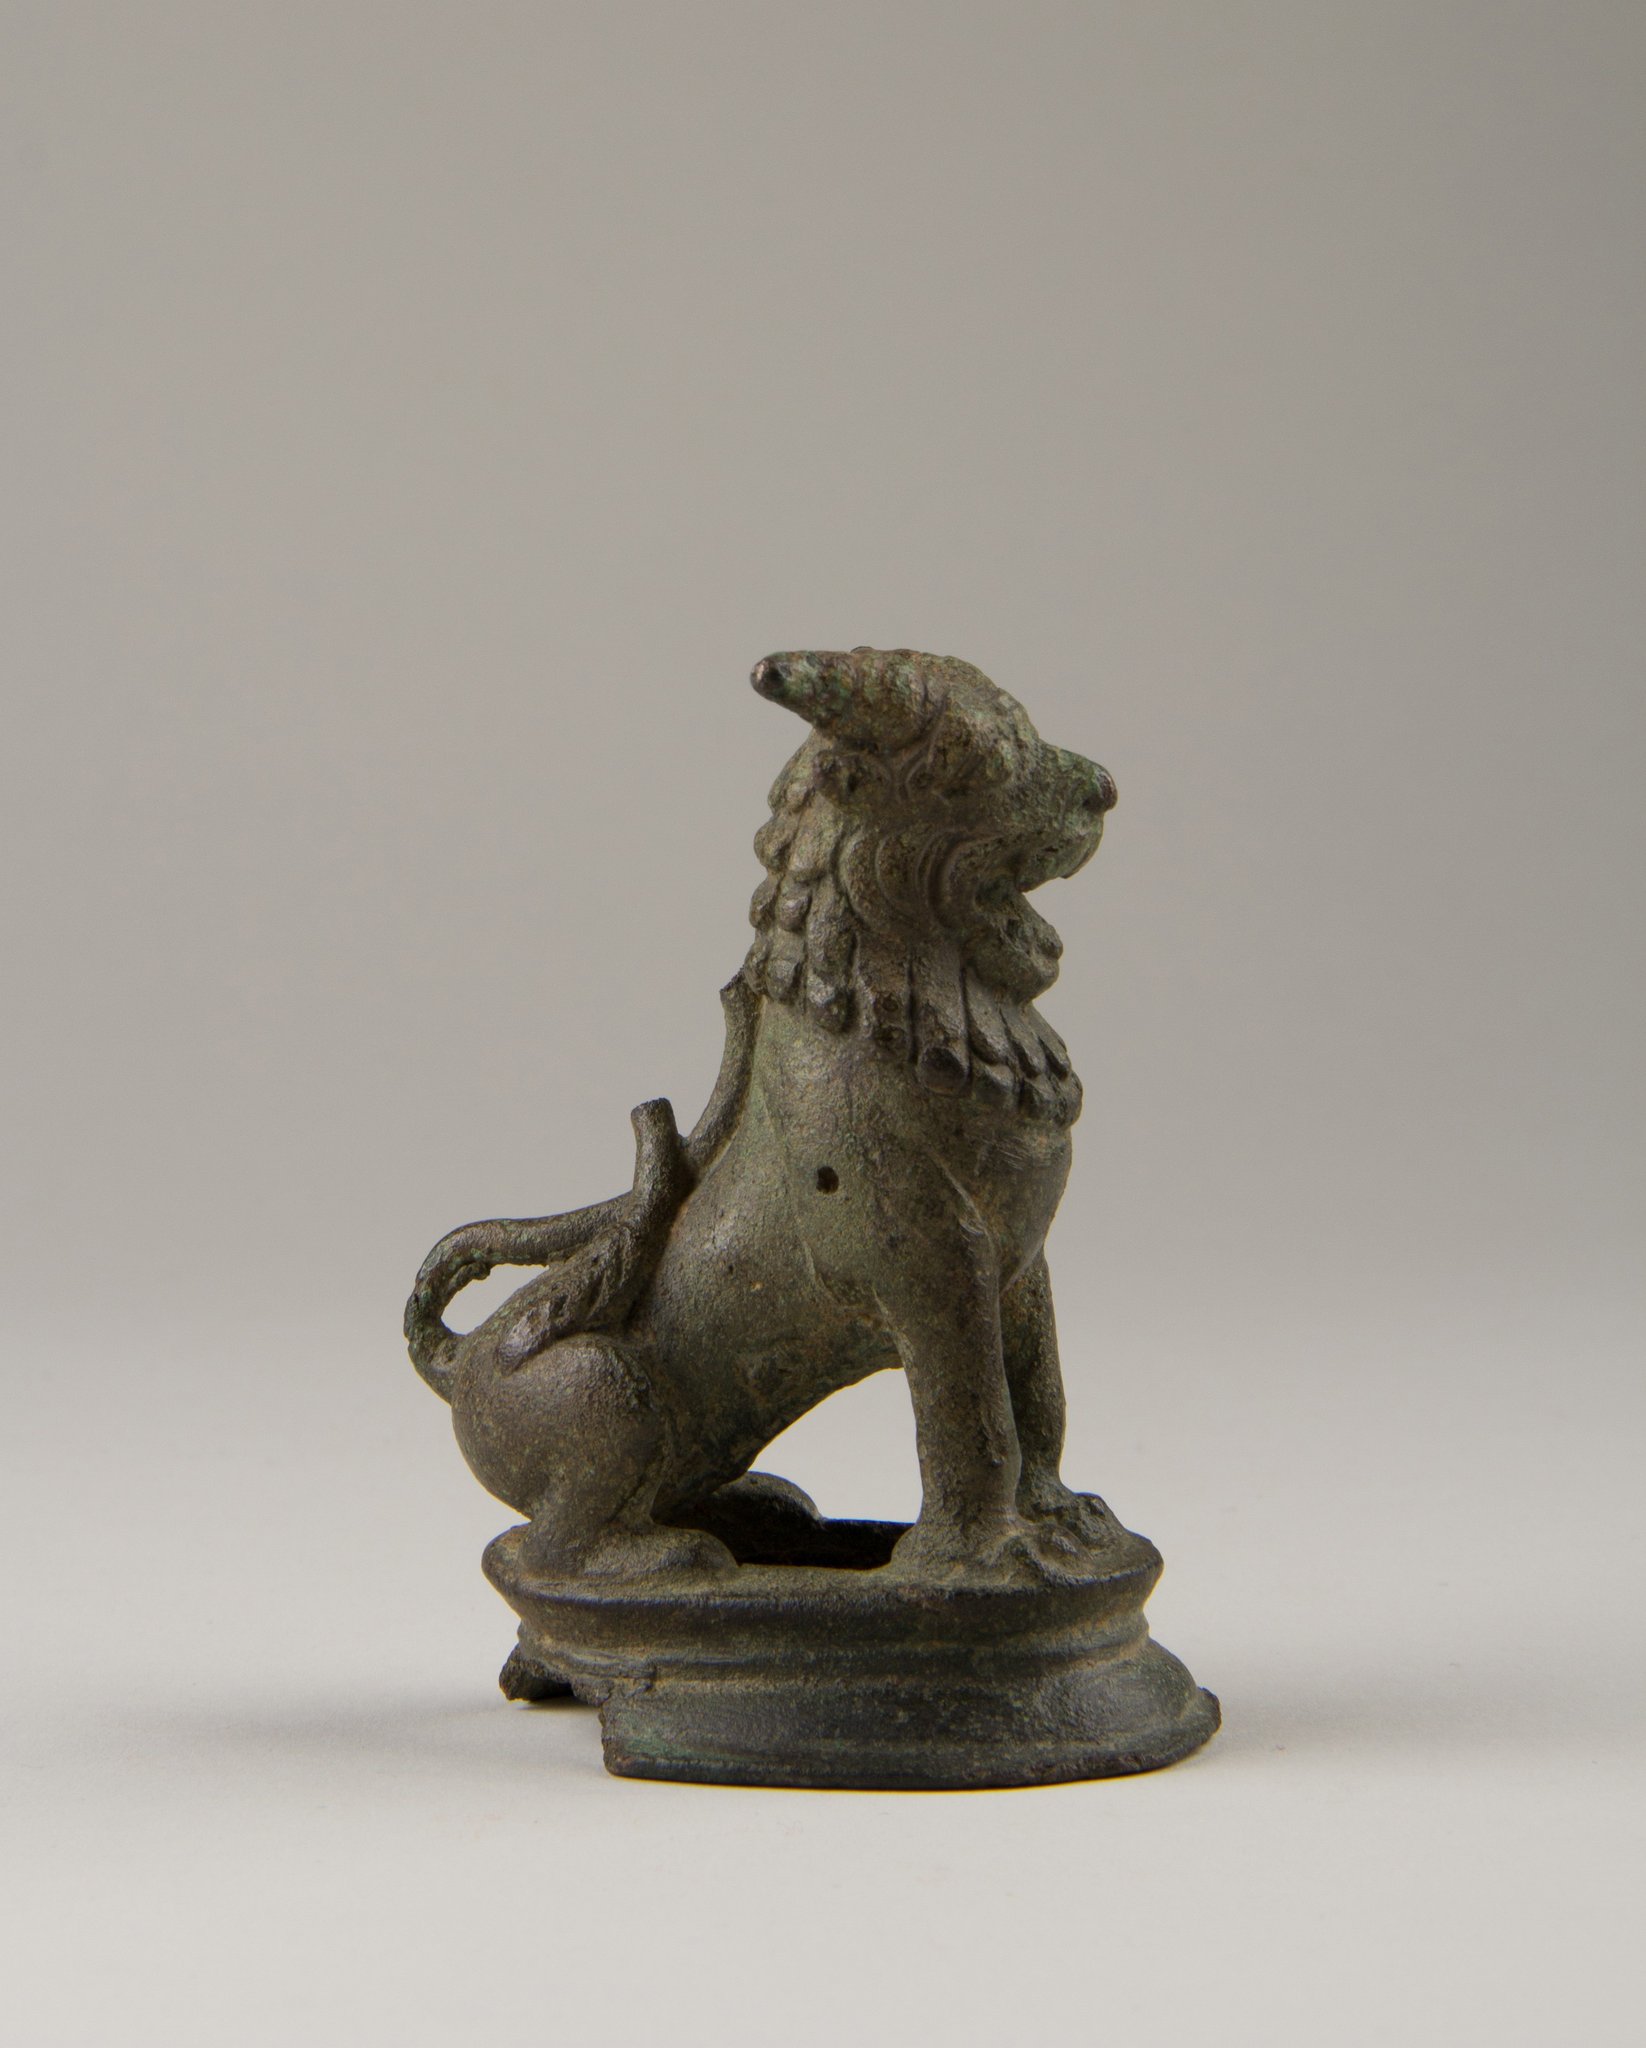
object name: figure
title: Horned Lion (Vyala)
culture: tamil nadu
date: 701-800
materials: bronze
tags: mythical creatures